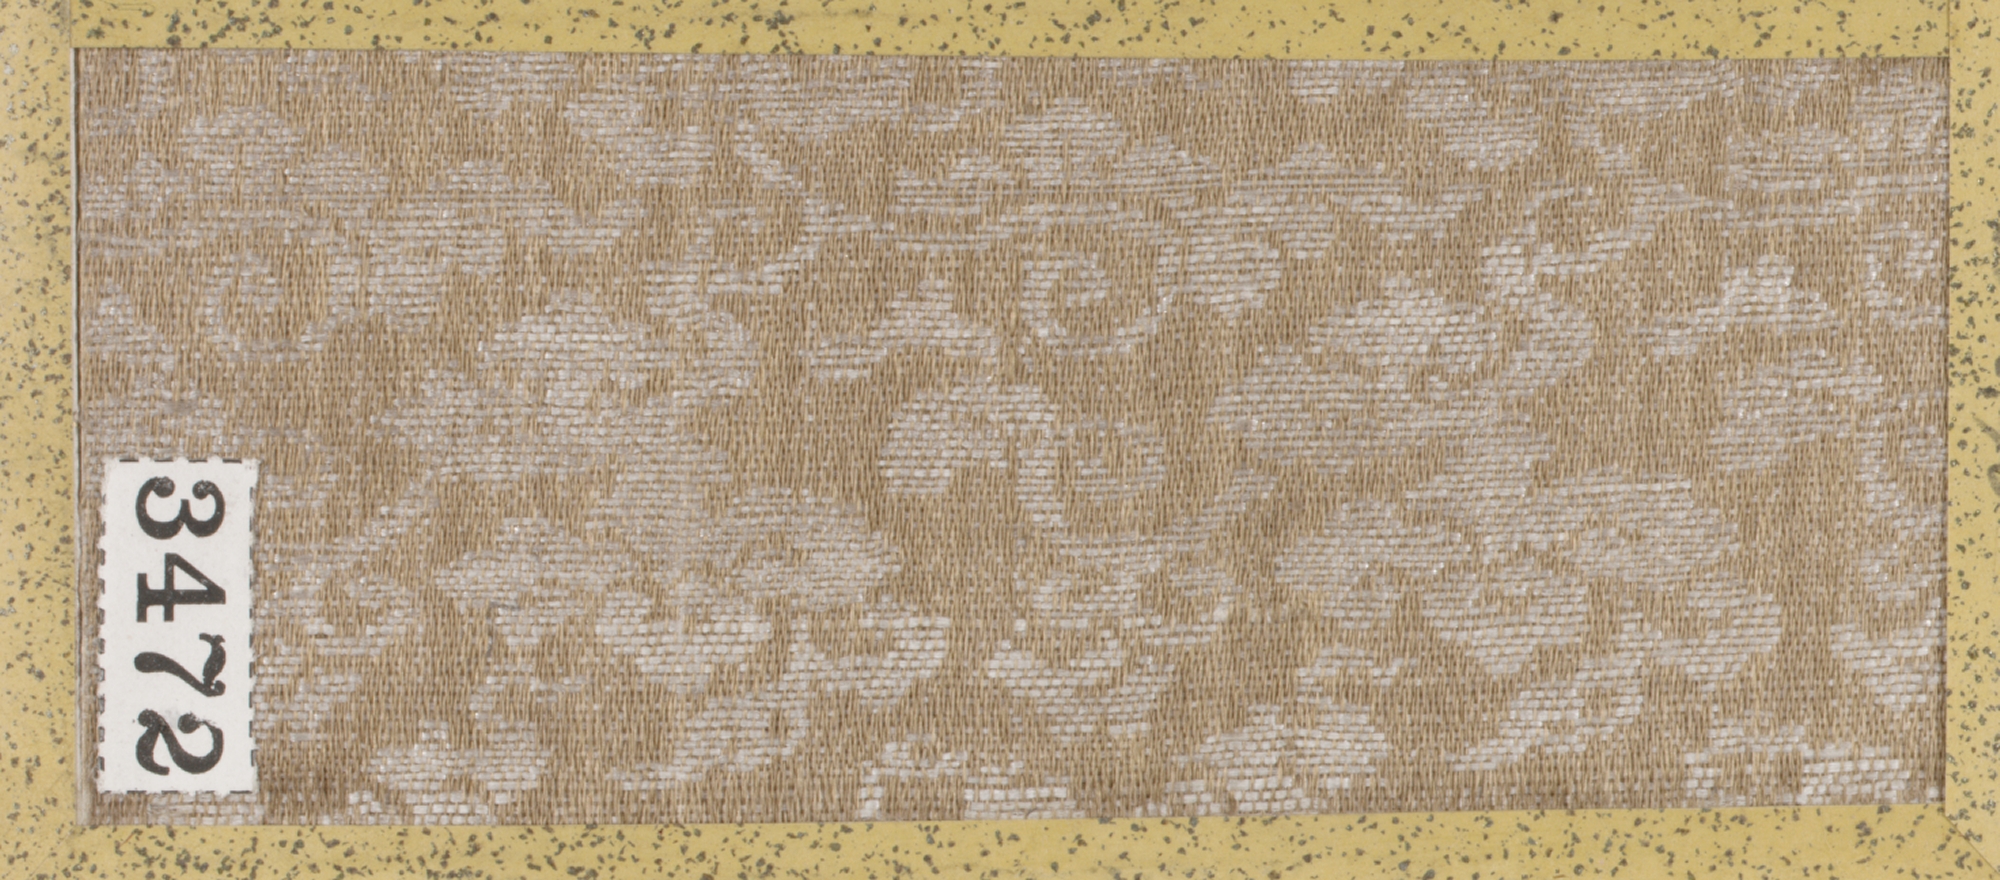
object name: sample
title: Textile Sample from Sample Book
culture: japanese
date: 1801-1900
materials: silk